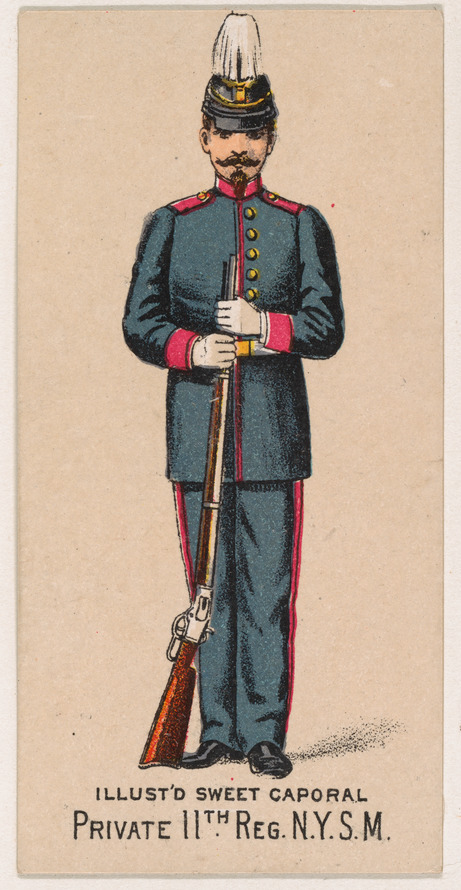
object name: print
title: Private, 11th Regiment, New York State Militia, from the Military Series (N224) issued by Kinney Tobacco Company to promote Sweet Caporal Cigarettes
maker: kinney brothers tobacco company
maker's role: publisher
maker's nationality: american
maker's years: 1869-2011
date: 1888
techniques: color lithograph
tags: military,soldiers,firearms,men